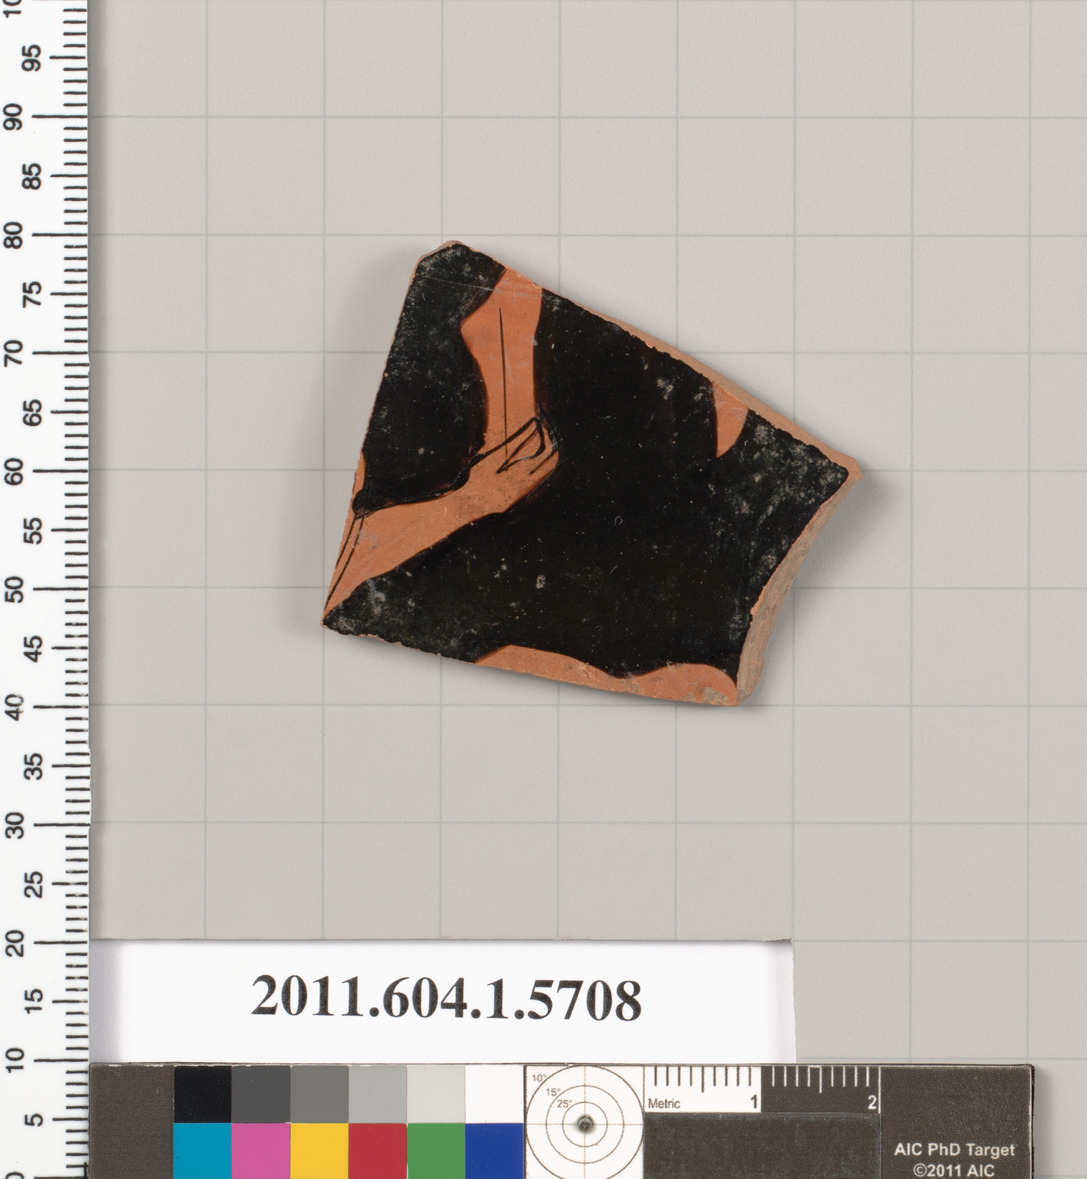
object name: kylix fragment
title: Terracotta fragment of a kylix (drinking cup)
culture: greek, attic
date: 475-451 BCE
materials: terracotta